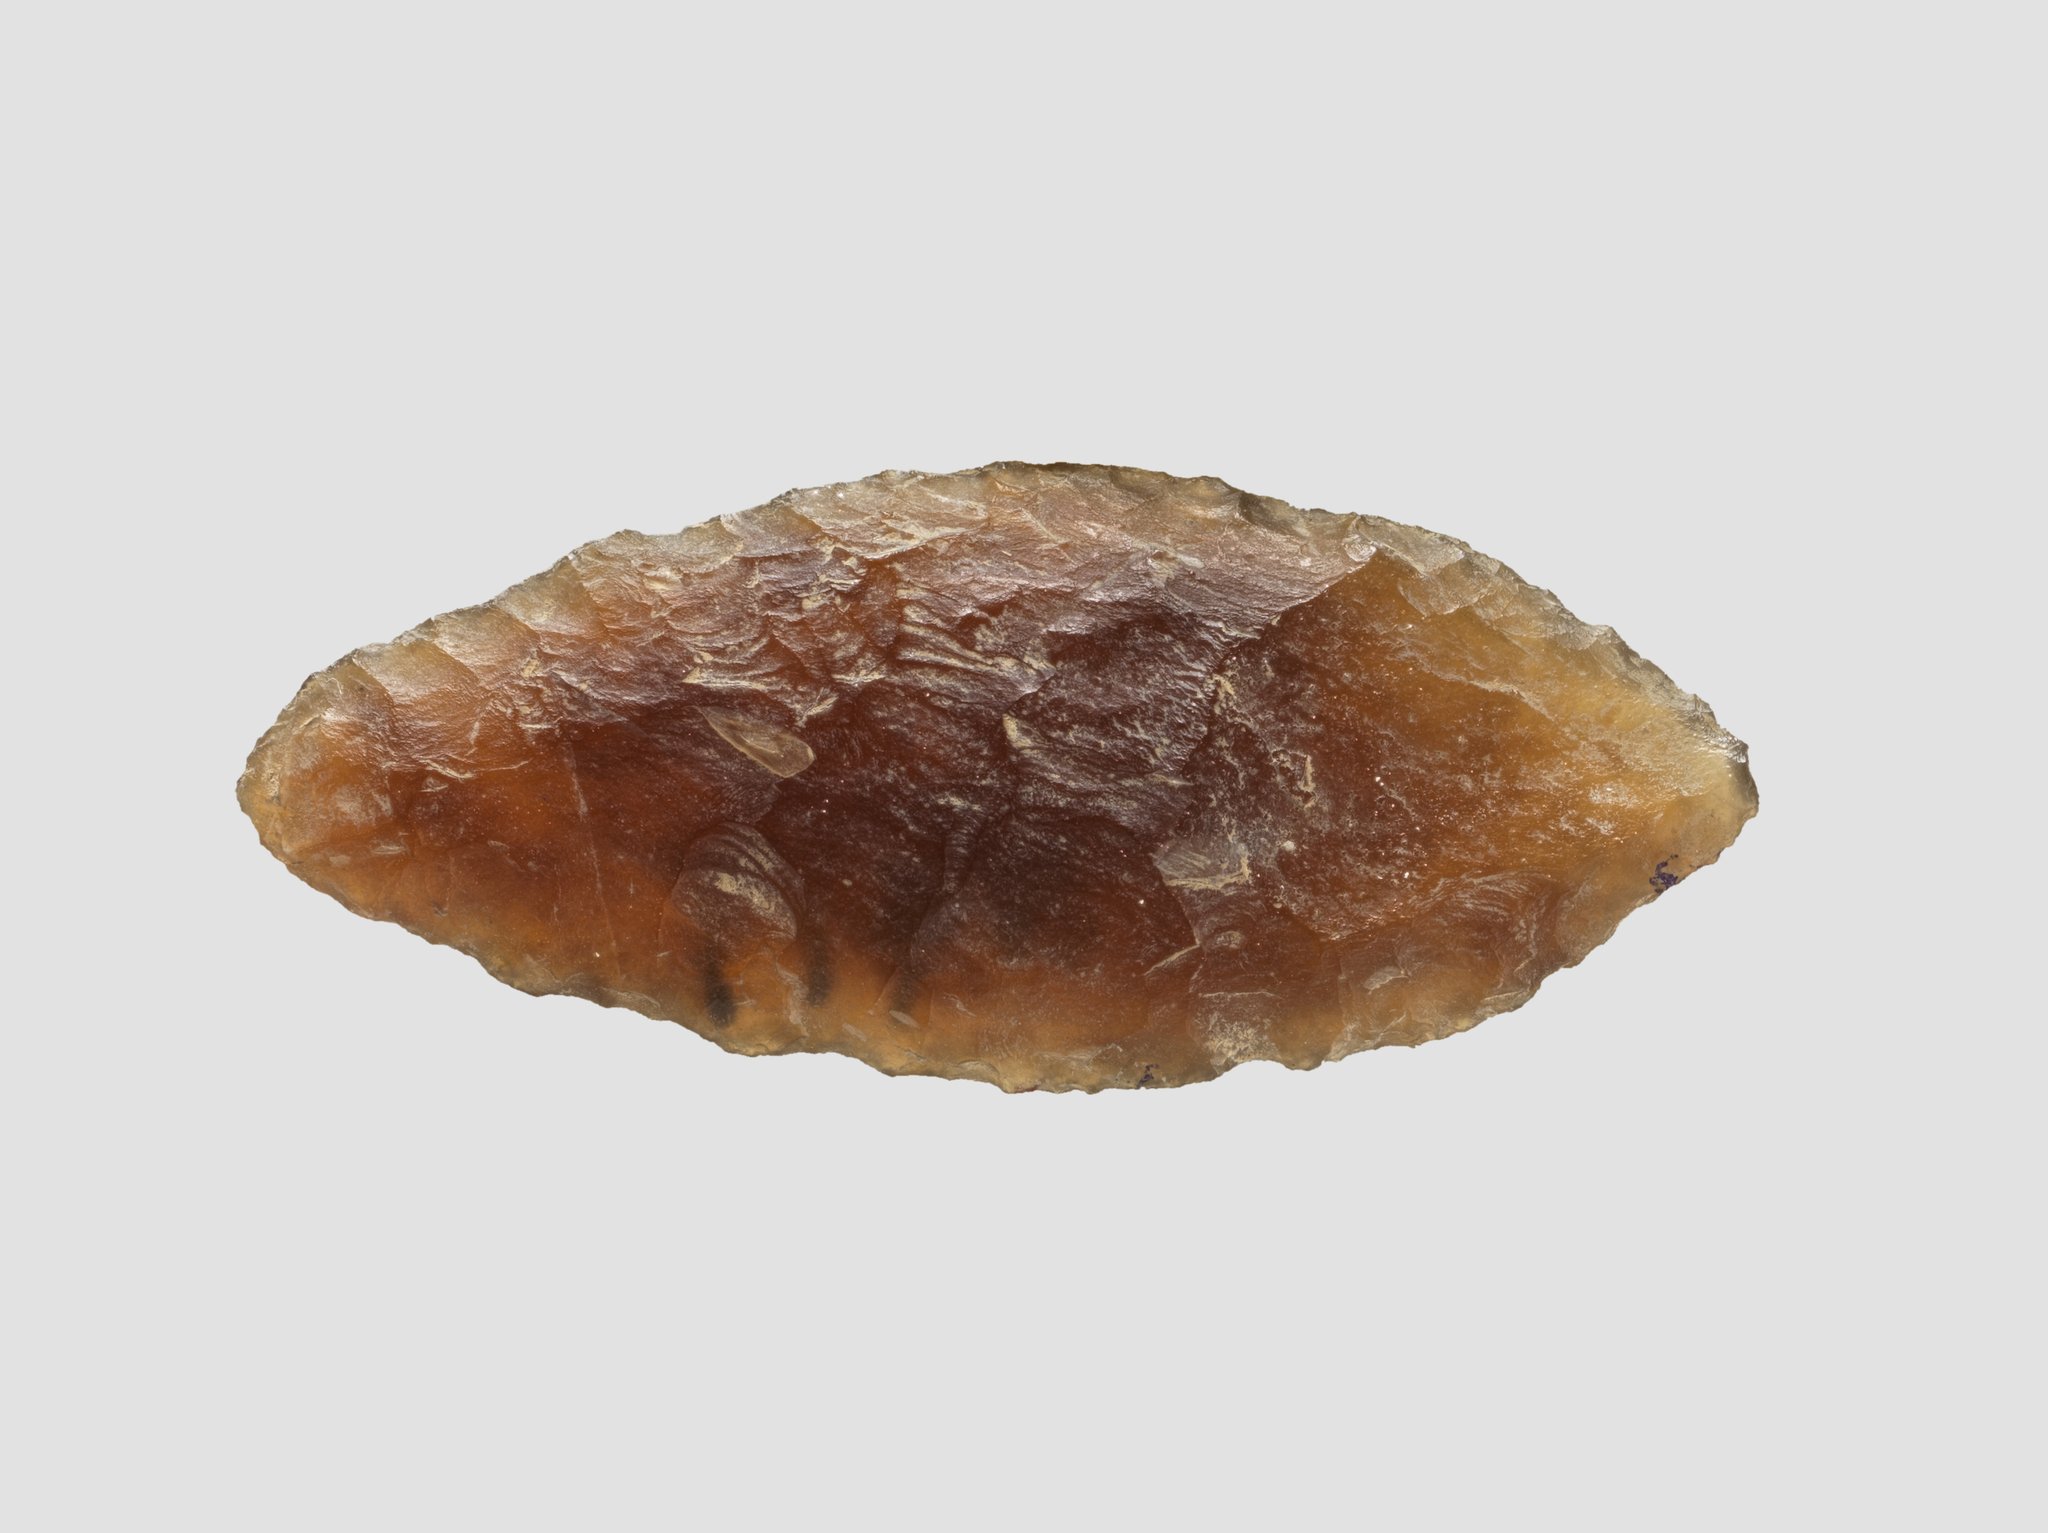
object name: tool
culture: iranian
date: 5000-2001 BCE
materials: stone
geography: iran